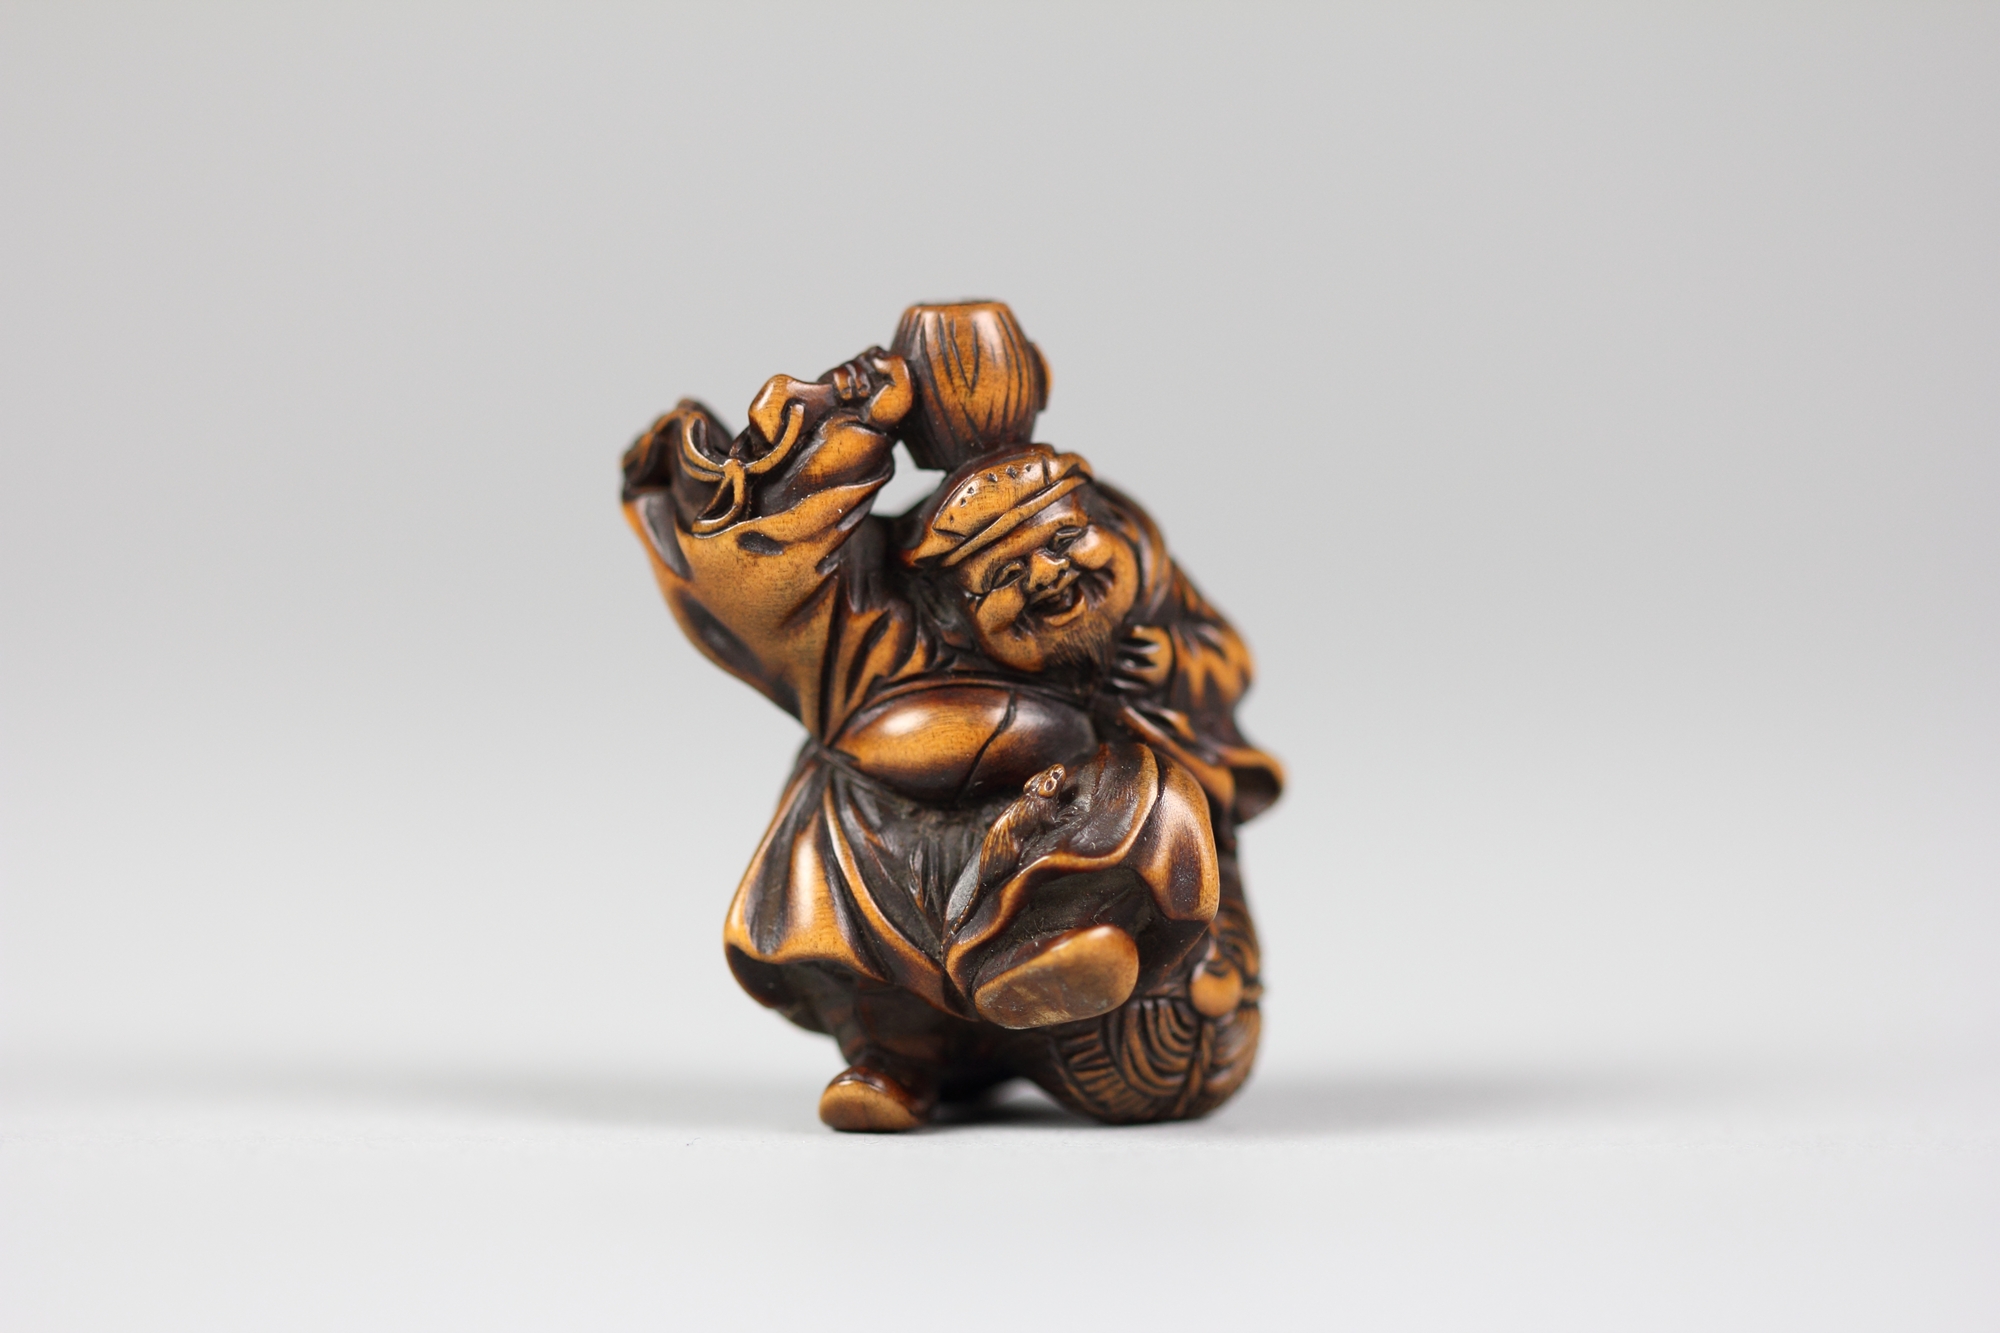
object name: netsuke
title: Netsuke of Daikoku and Mallet on Bale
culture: japanese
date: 1801-1900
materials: wood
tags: men,mice